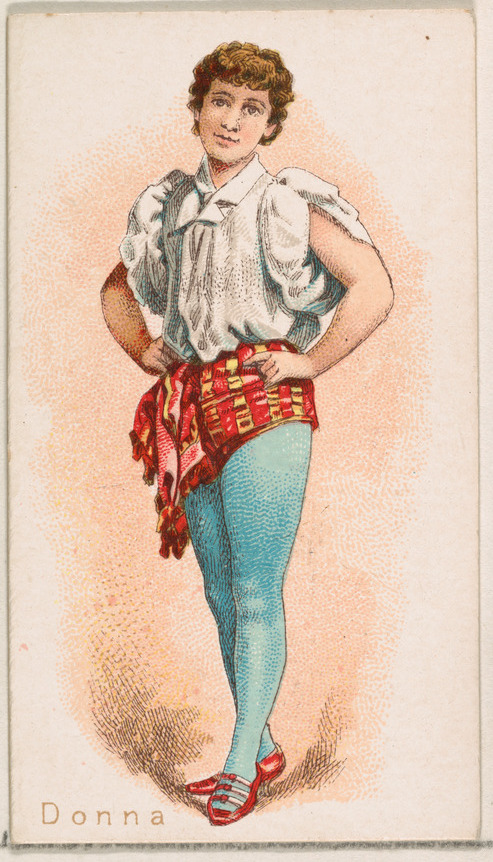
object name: print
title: Donna, from the Ballet Queens series (N182) issued by Wm. S. Kimball & Co.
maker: william s. kimball & company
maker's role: publisher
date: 1889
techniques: color lithograph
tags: women,dancers